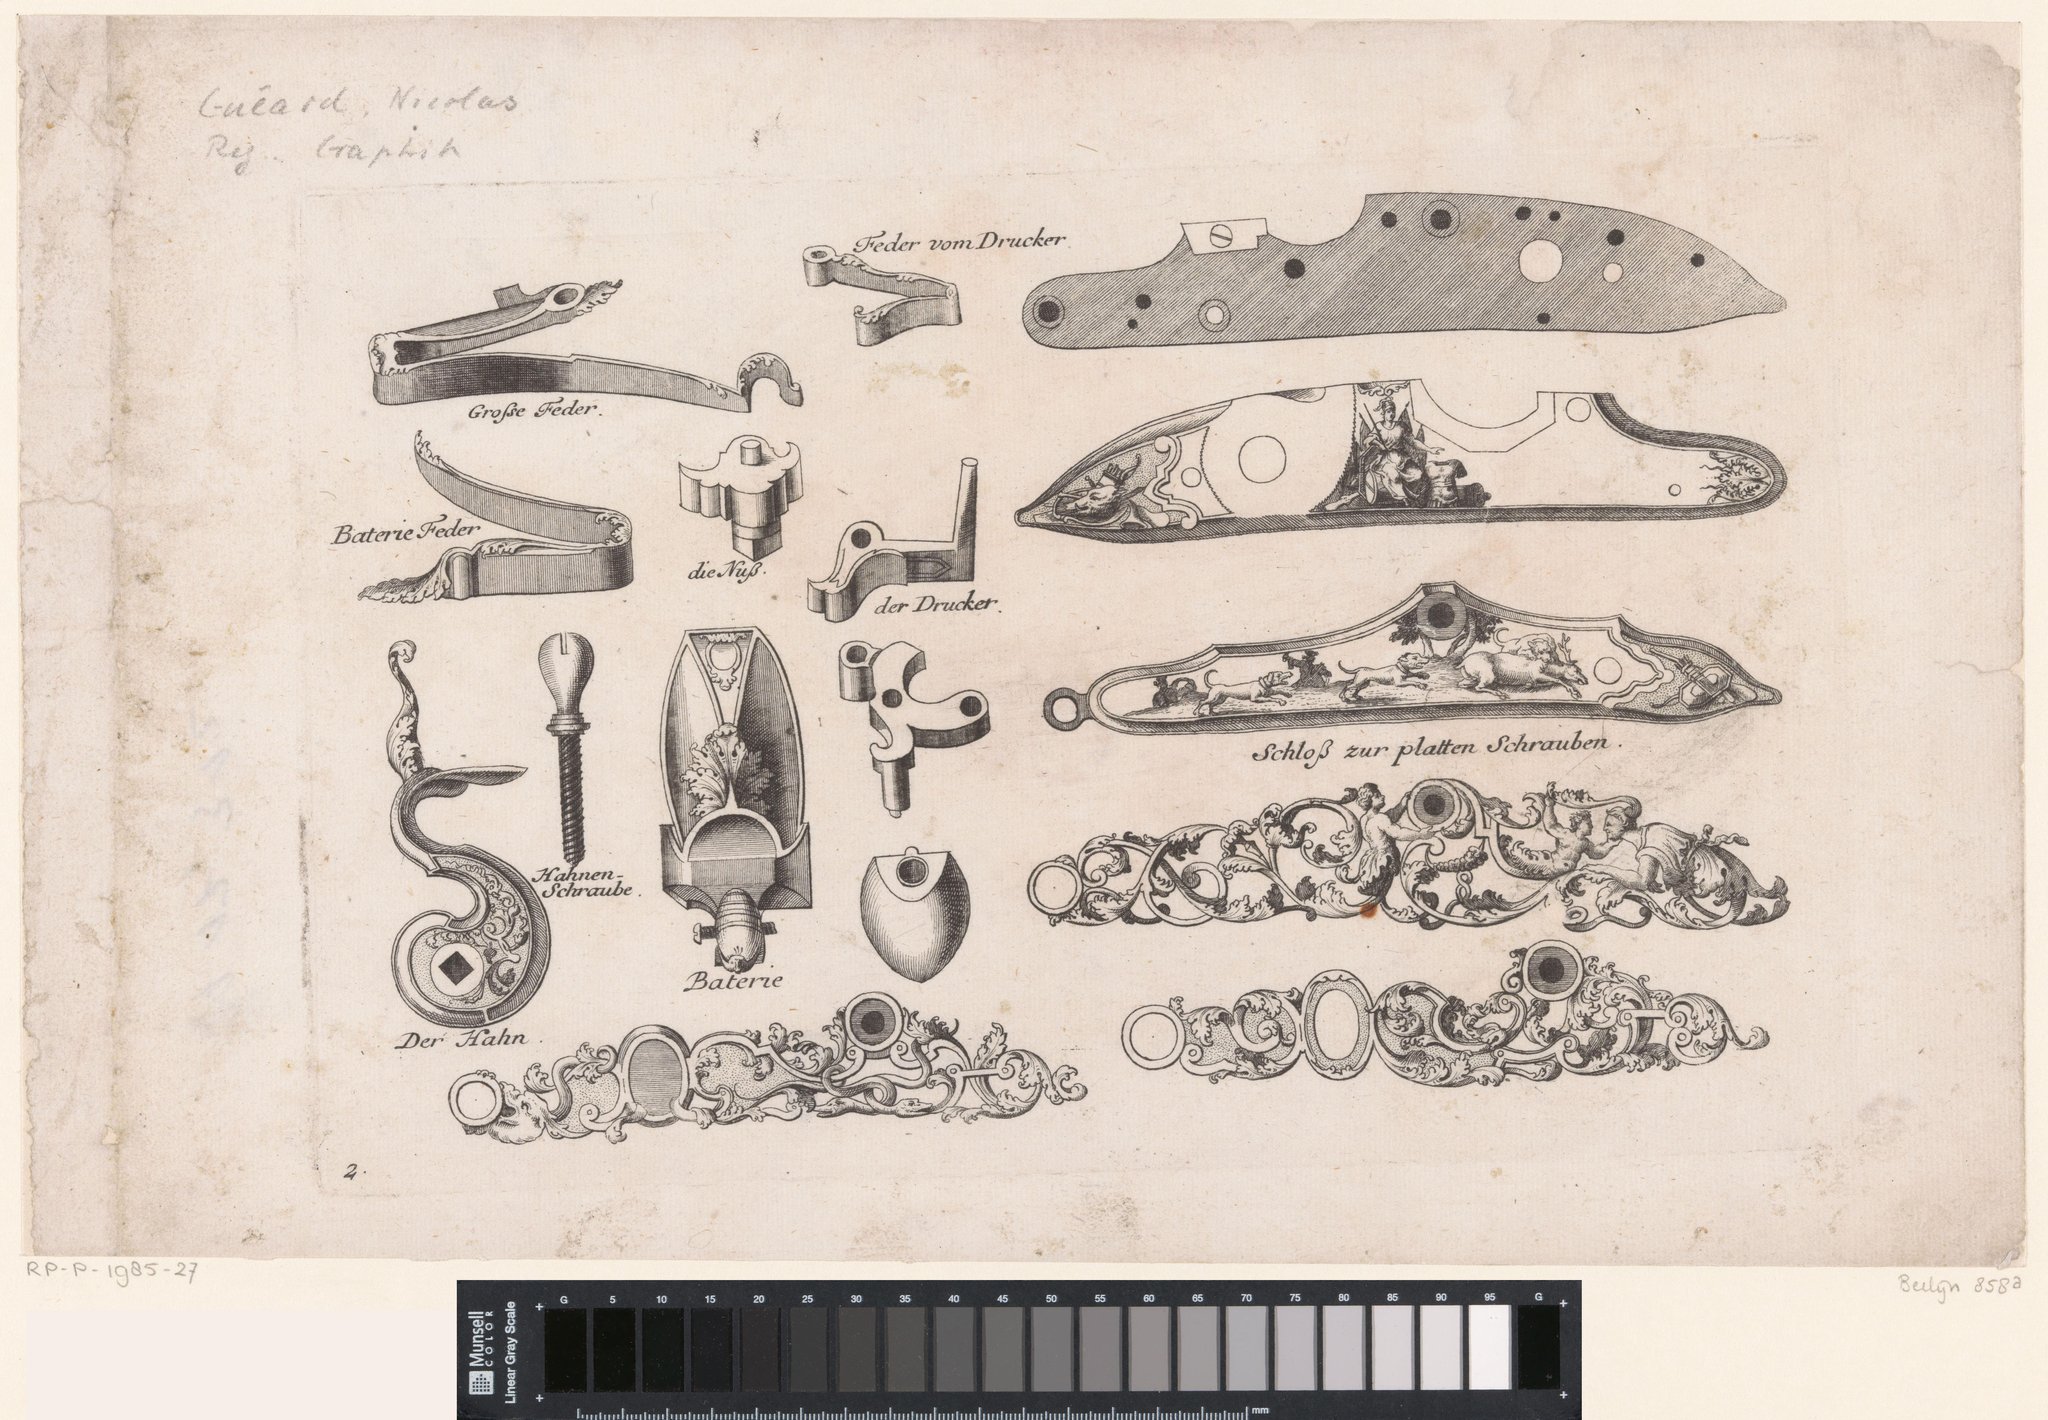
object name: print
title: Onderdelen van vuurwapens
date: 1690-1725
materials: paper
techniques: etching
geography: nuremberg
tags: weapons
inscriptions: collector's mark: Lugt 2760, collector's mark: Lugt 2228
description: Geornamenteerde onderdelen van vuurwapens zoals links boven drie veren, links onder een haan en rechts zes schroefplaten. Met Duitse beschrijving.